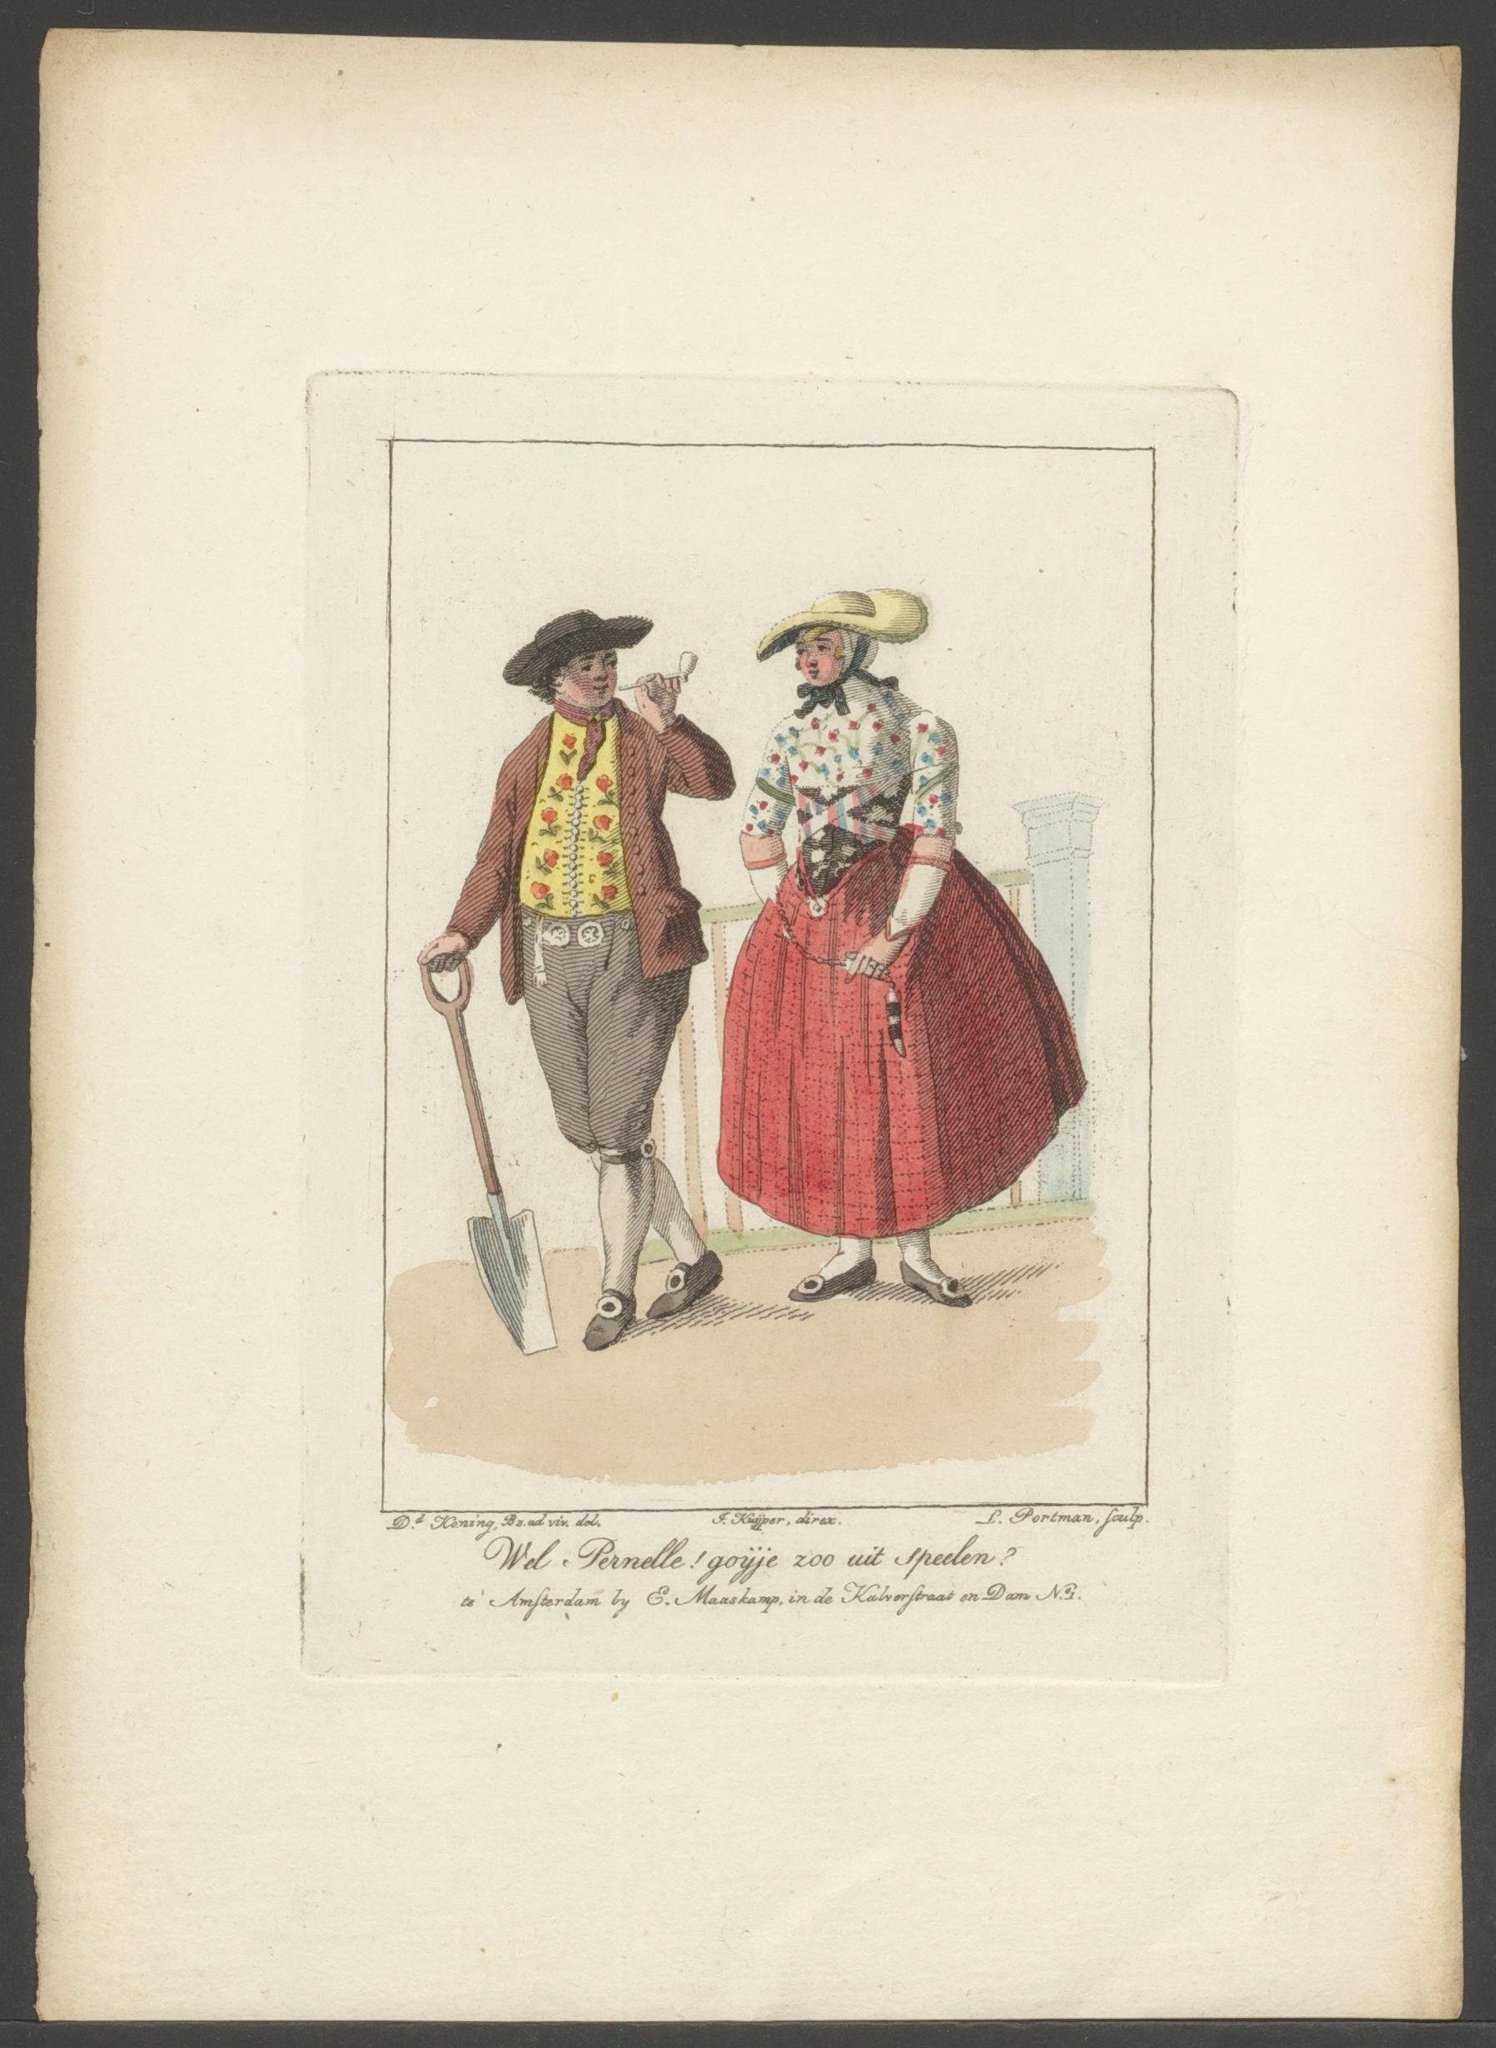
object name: print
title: Wel Pernelle! goyje zoo uit speelen?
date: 1813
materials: paper, watercolor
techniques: etching, hand coloring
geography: netherlands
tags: farmers, farmers - aa - female farmer, farmer's wife, clothes, costume (+ women's clothes), clothes, costume (+ men's clothes), agricultural implements: spade, folk costume, regional costume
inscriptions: collector's mark: Lugt 1641, collector's mark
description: Boer en boerin uit Walcheren. Een jonge dame in geruite rok, gebloemd bovenstuk en hoed op, staat naast een heer met pijp en spade. Bij de prent zit ook een blad met de Franse titel. Onderdeel van de verkleinde kopieën uit 1812 naar de platen van Nederlandse klederdrachten uit de jaren 1803-1807. Onderwerpsrubrieken binnen de Atlas Zeden en Gewoonten: De Kleeding, Volkskleederdracht.